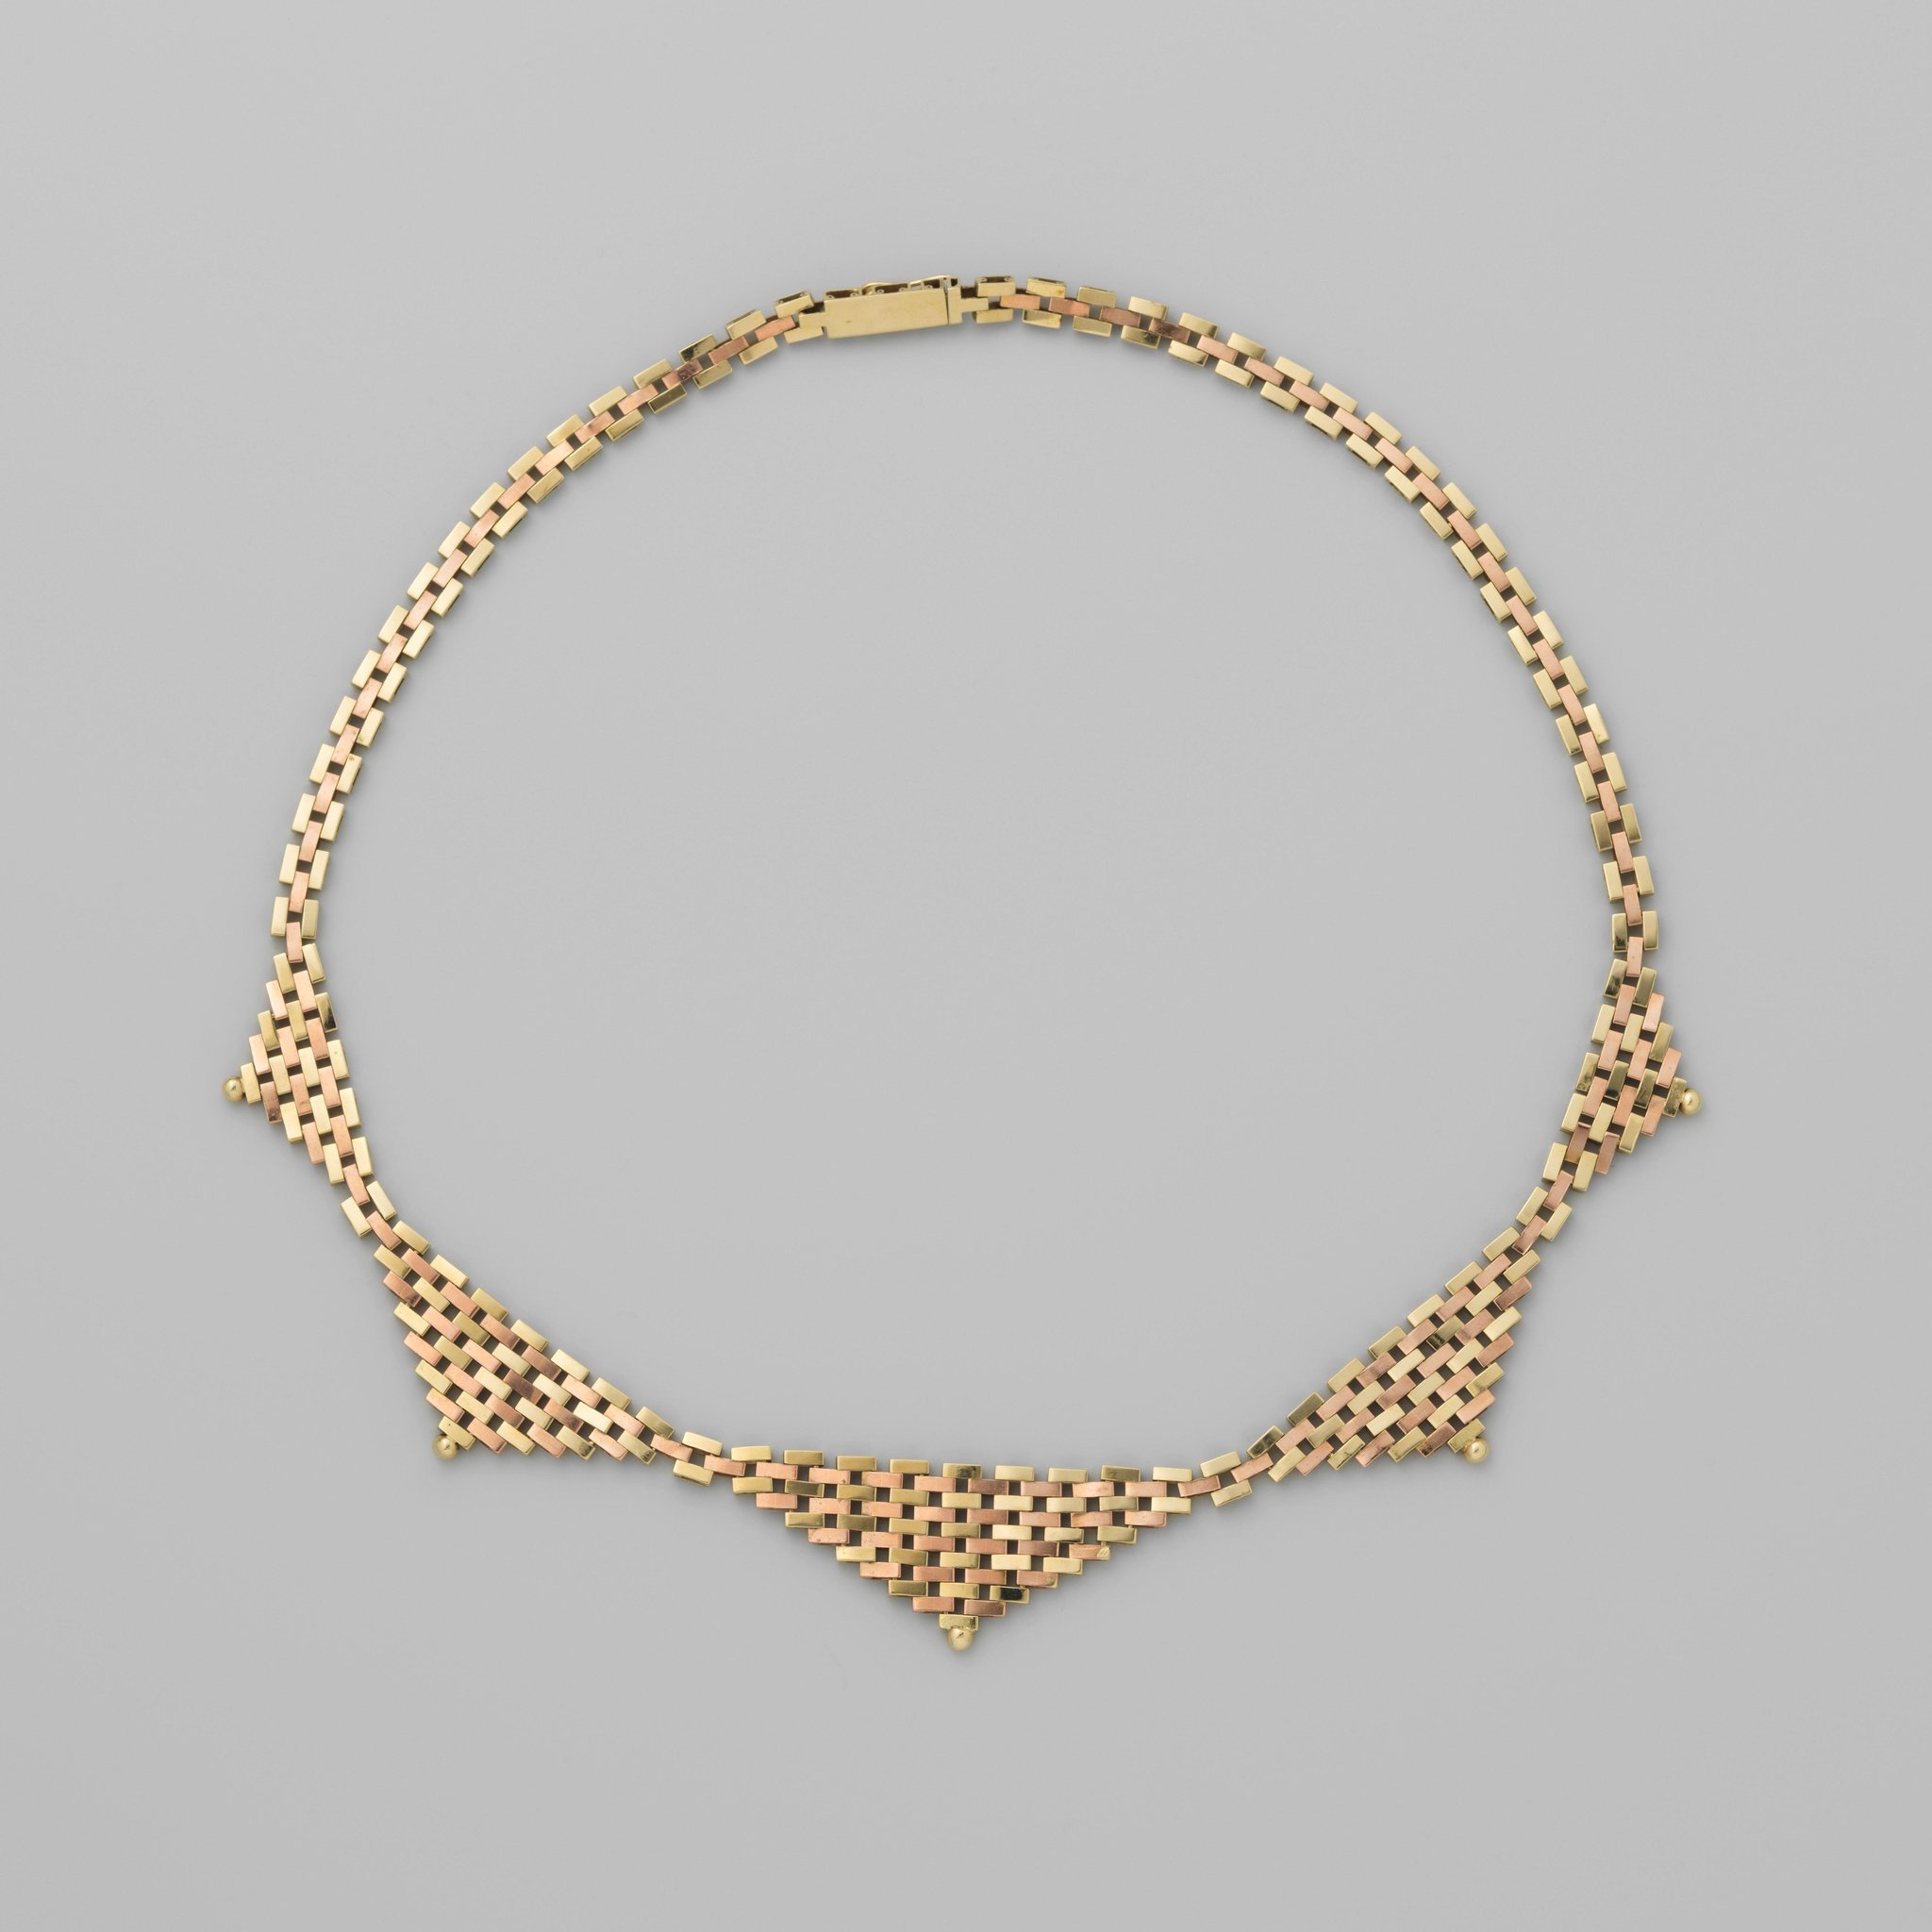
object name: necklace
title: Collier van goud in twee kleuren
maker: Anonymous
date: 1953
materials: gold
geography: netherlands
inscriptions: maker's mark, alloy mark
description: Collier van gouden baksteenschakels in twee kleuren goud (rood en geel), voorzien van een baksluiting met een veiligheidsacht.